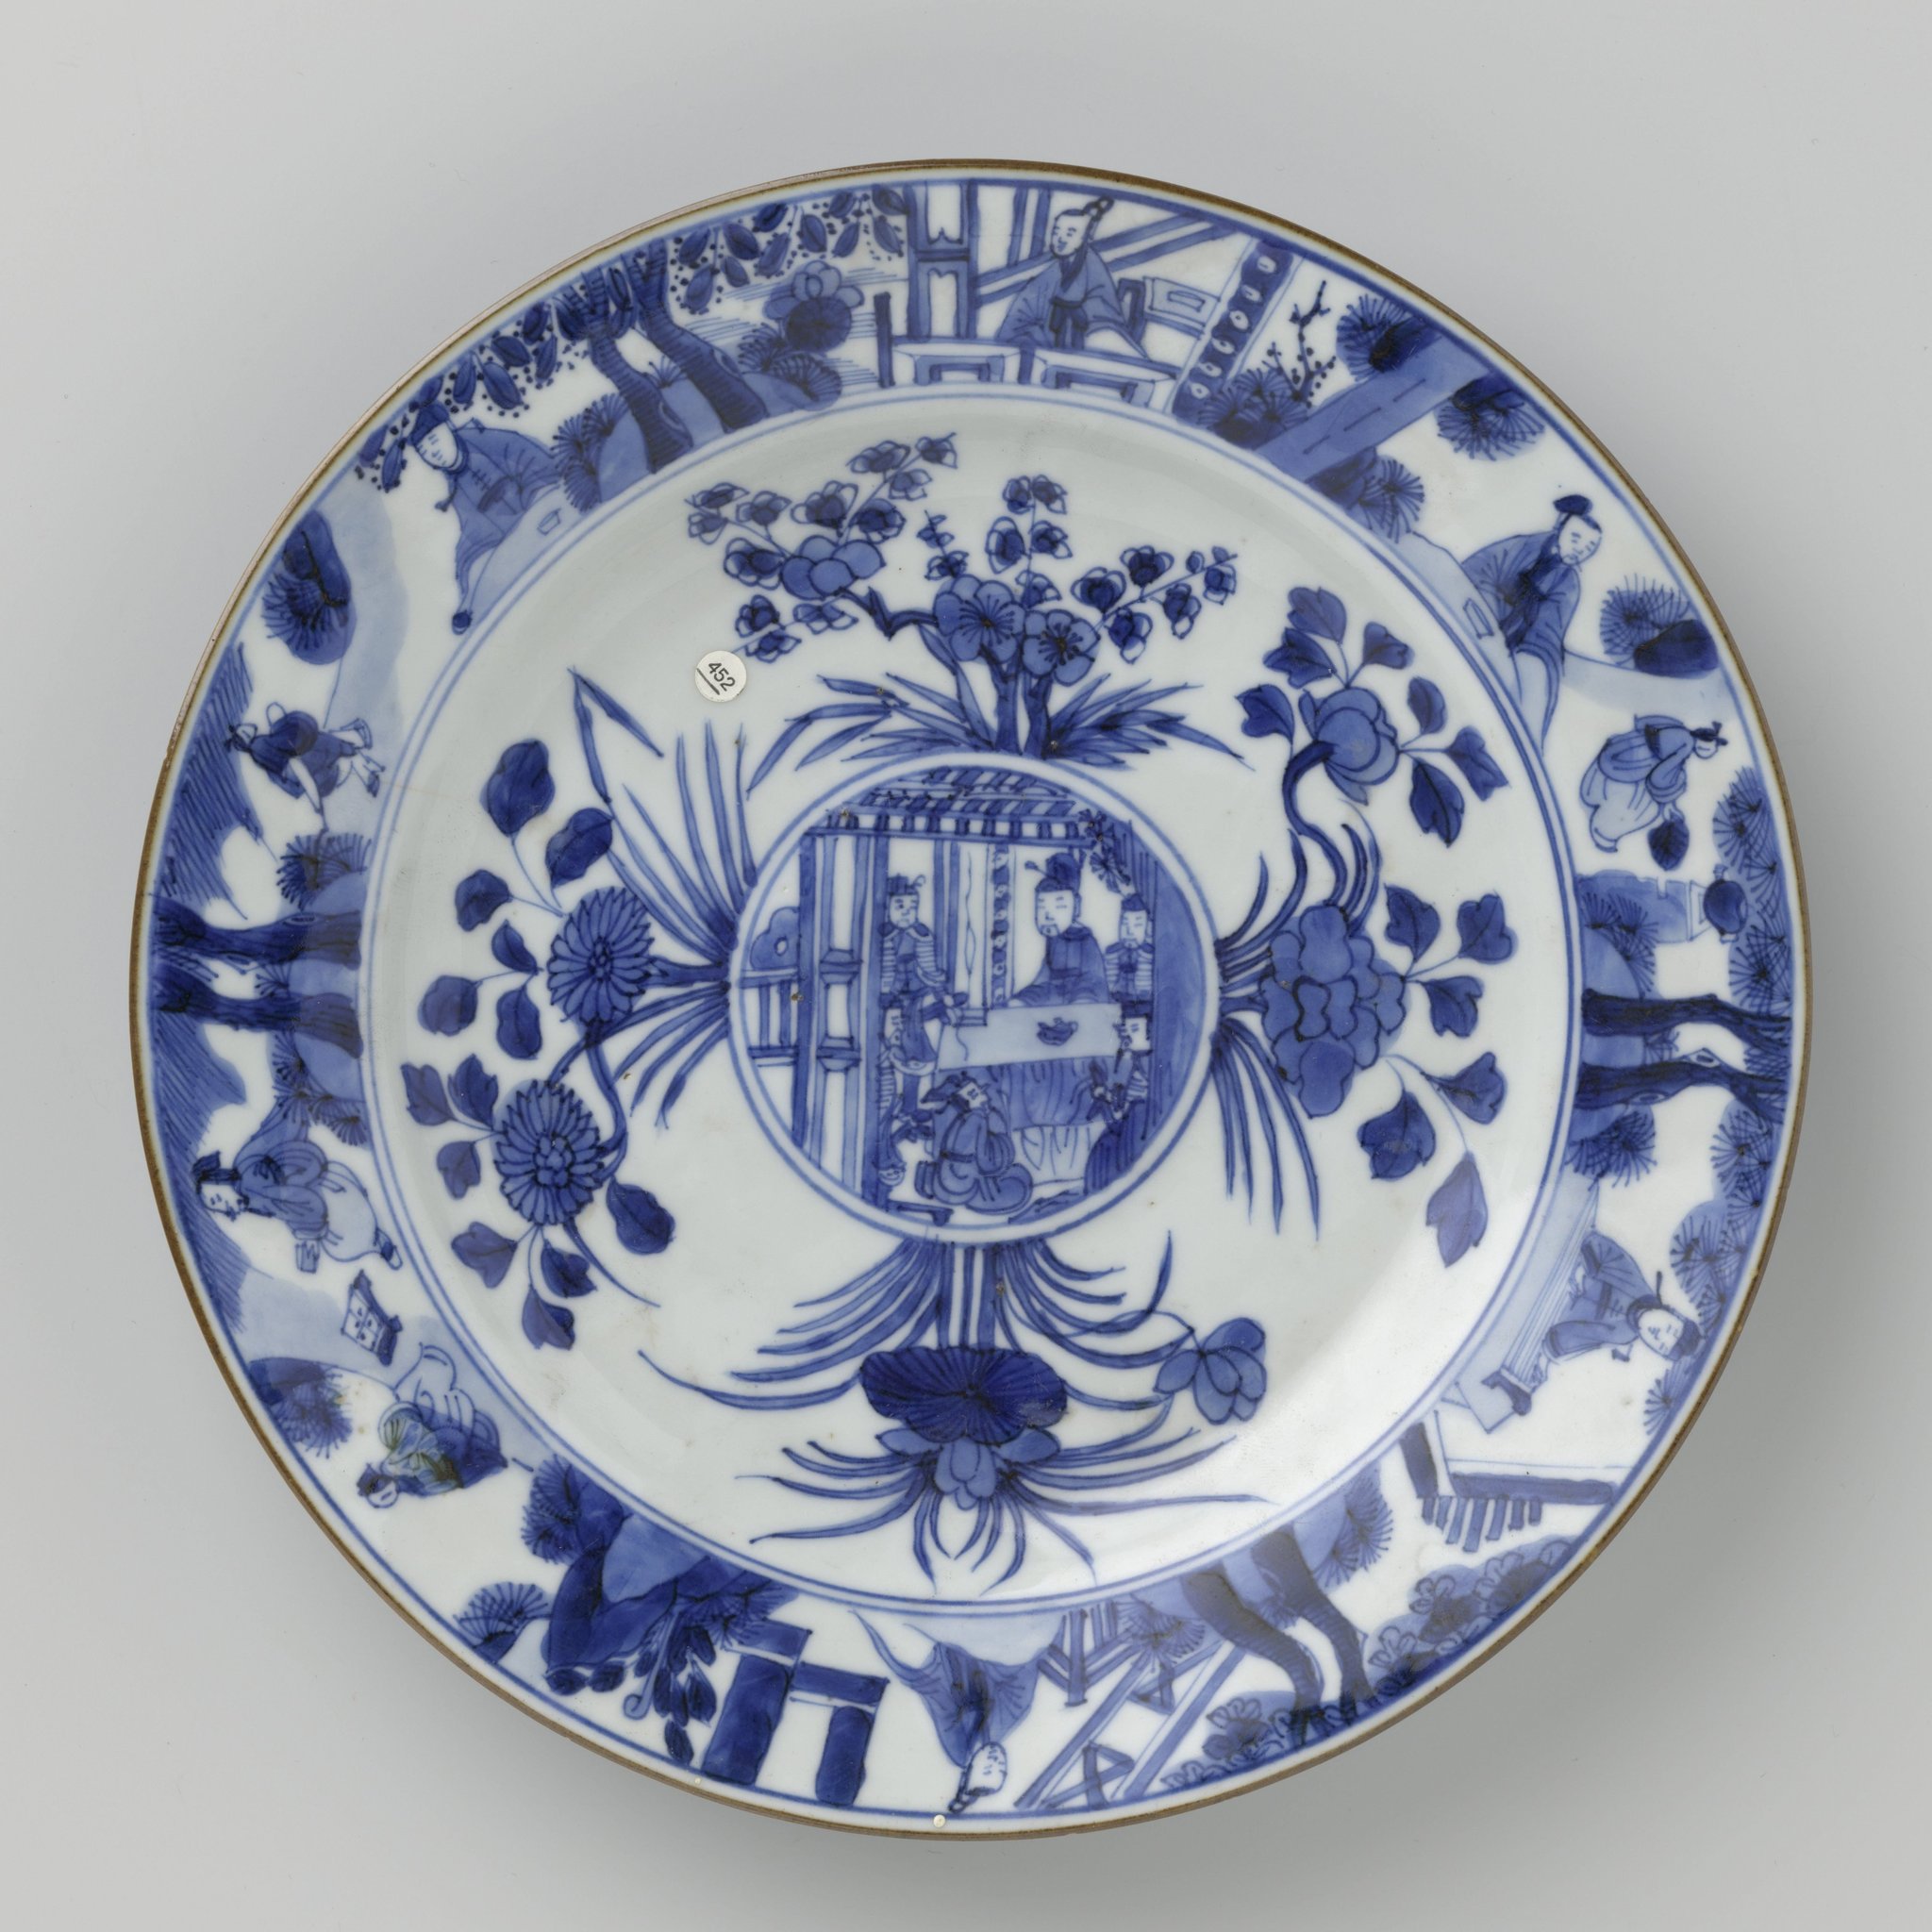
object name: plate dish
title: Plate with flower sprays and figures in an interior and in a landscape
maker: Anonymous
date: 1700-1724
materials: cobalt, glaze, paint, porcelain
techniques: firing, turning, vitrification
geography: china